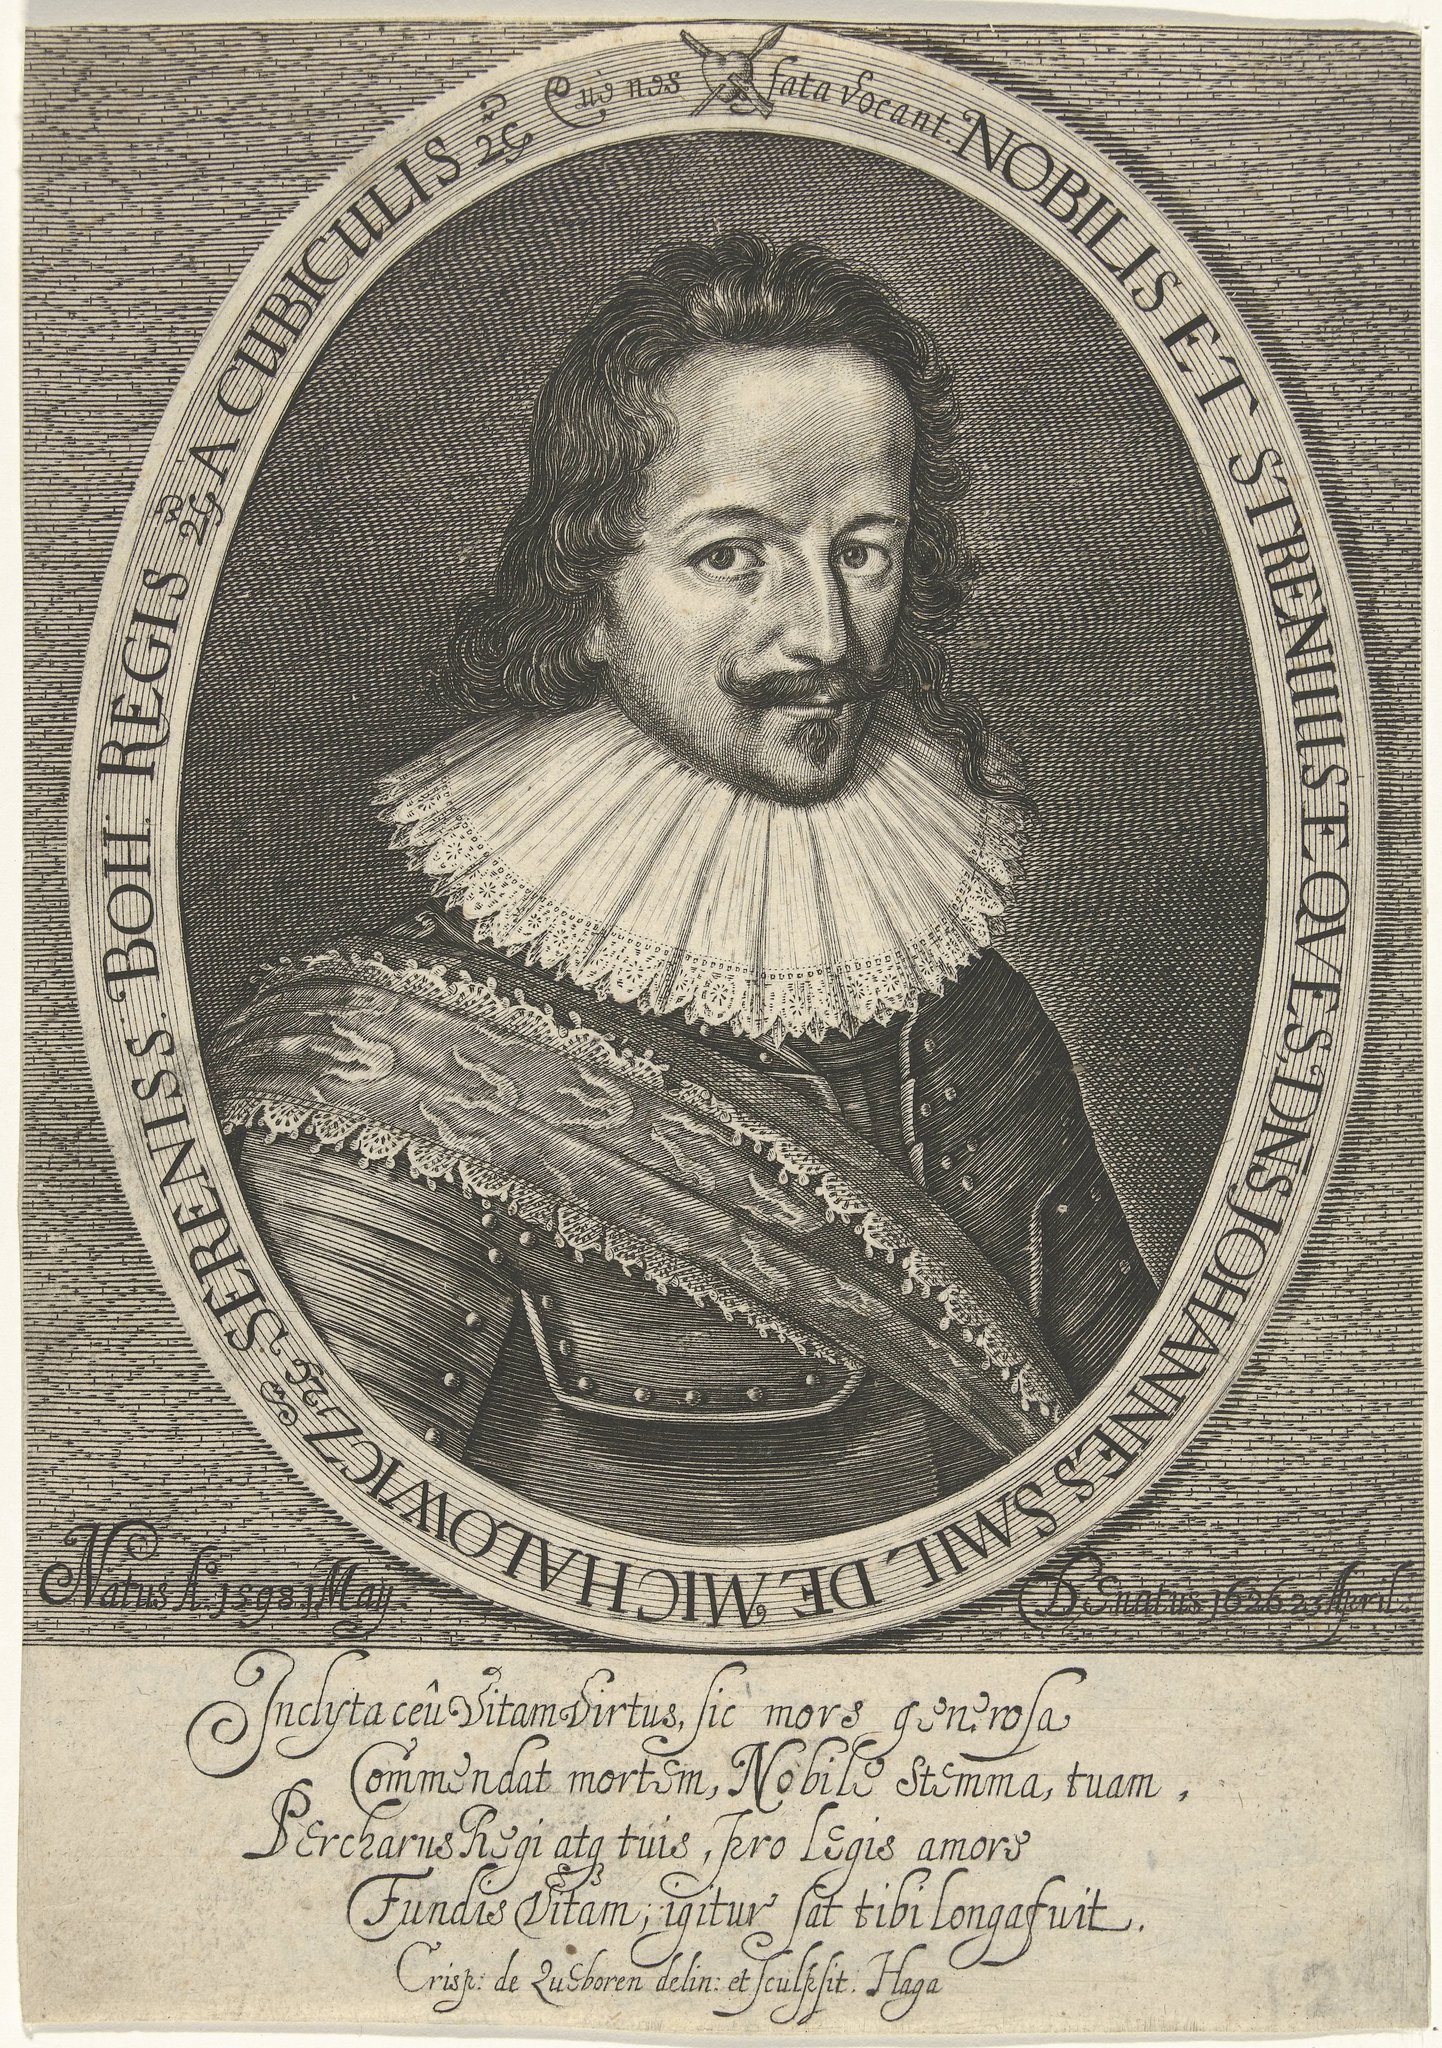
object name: print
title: Portret van Johannes Smil de Michalowicz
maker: crispijn van den queborn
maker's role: print maker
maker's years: 1595-1652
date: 1626-1652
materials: paper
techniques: engraving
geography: the hague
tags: johannes smil de michalowicz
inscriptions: collector's mark: Lugt 2228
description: Johannes Smil de Michalowicz, gevat in een lijst met een hart dat doorboord is door een pijl en een pistool. Rechts en links van het portret diens geboorte- en sterfdatum. In de marge een vierregelig onderschrift in het Latijn.